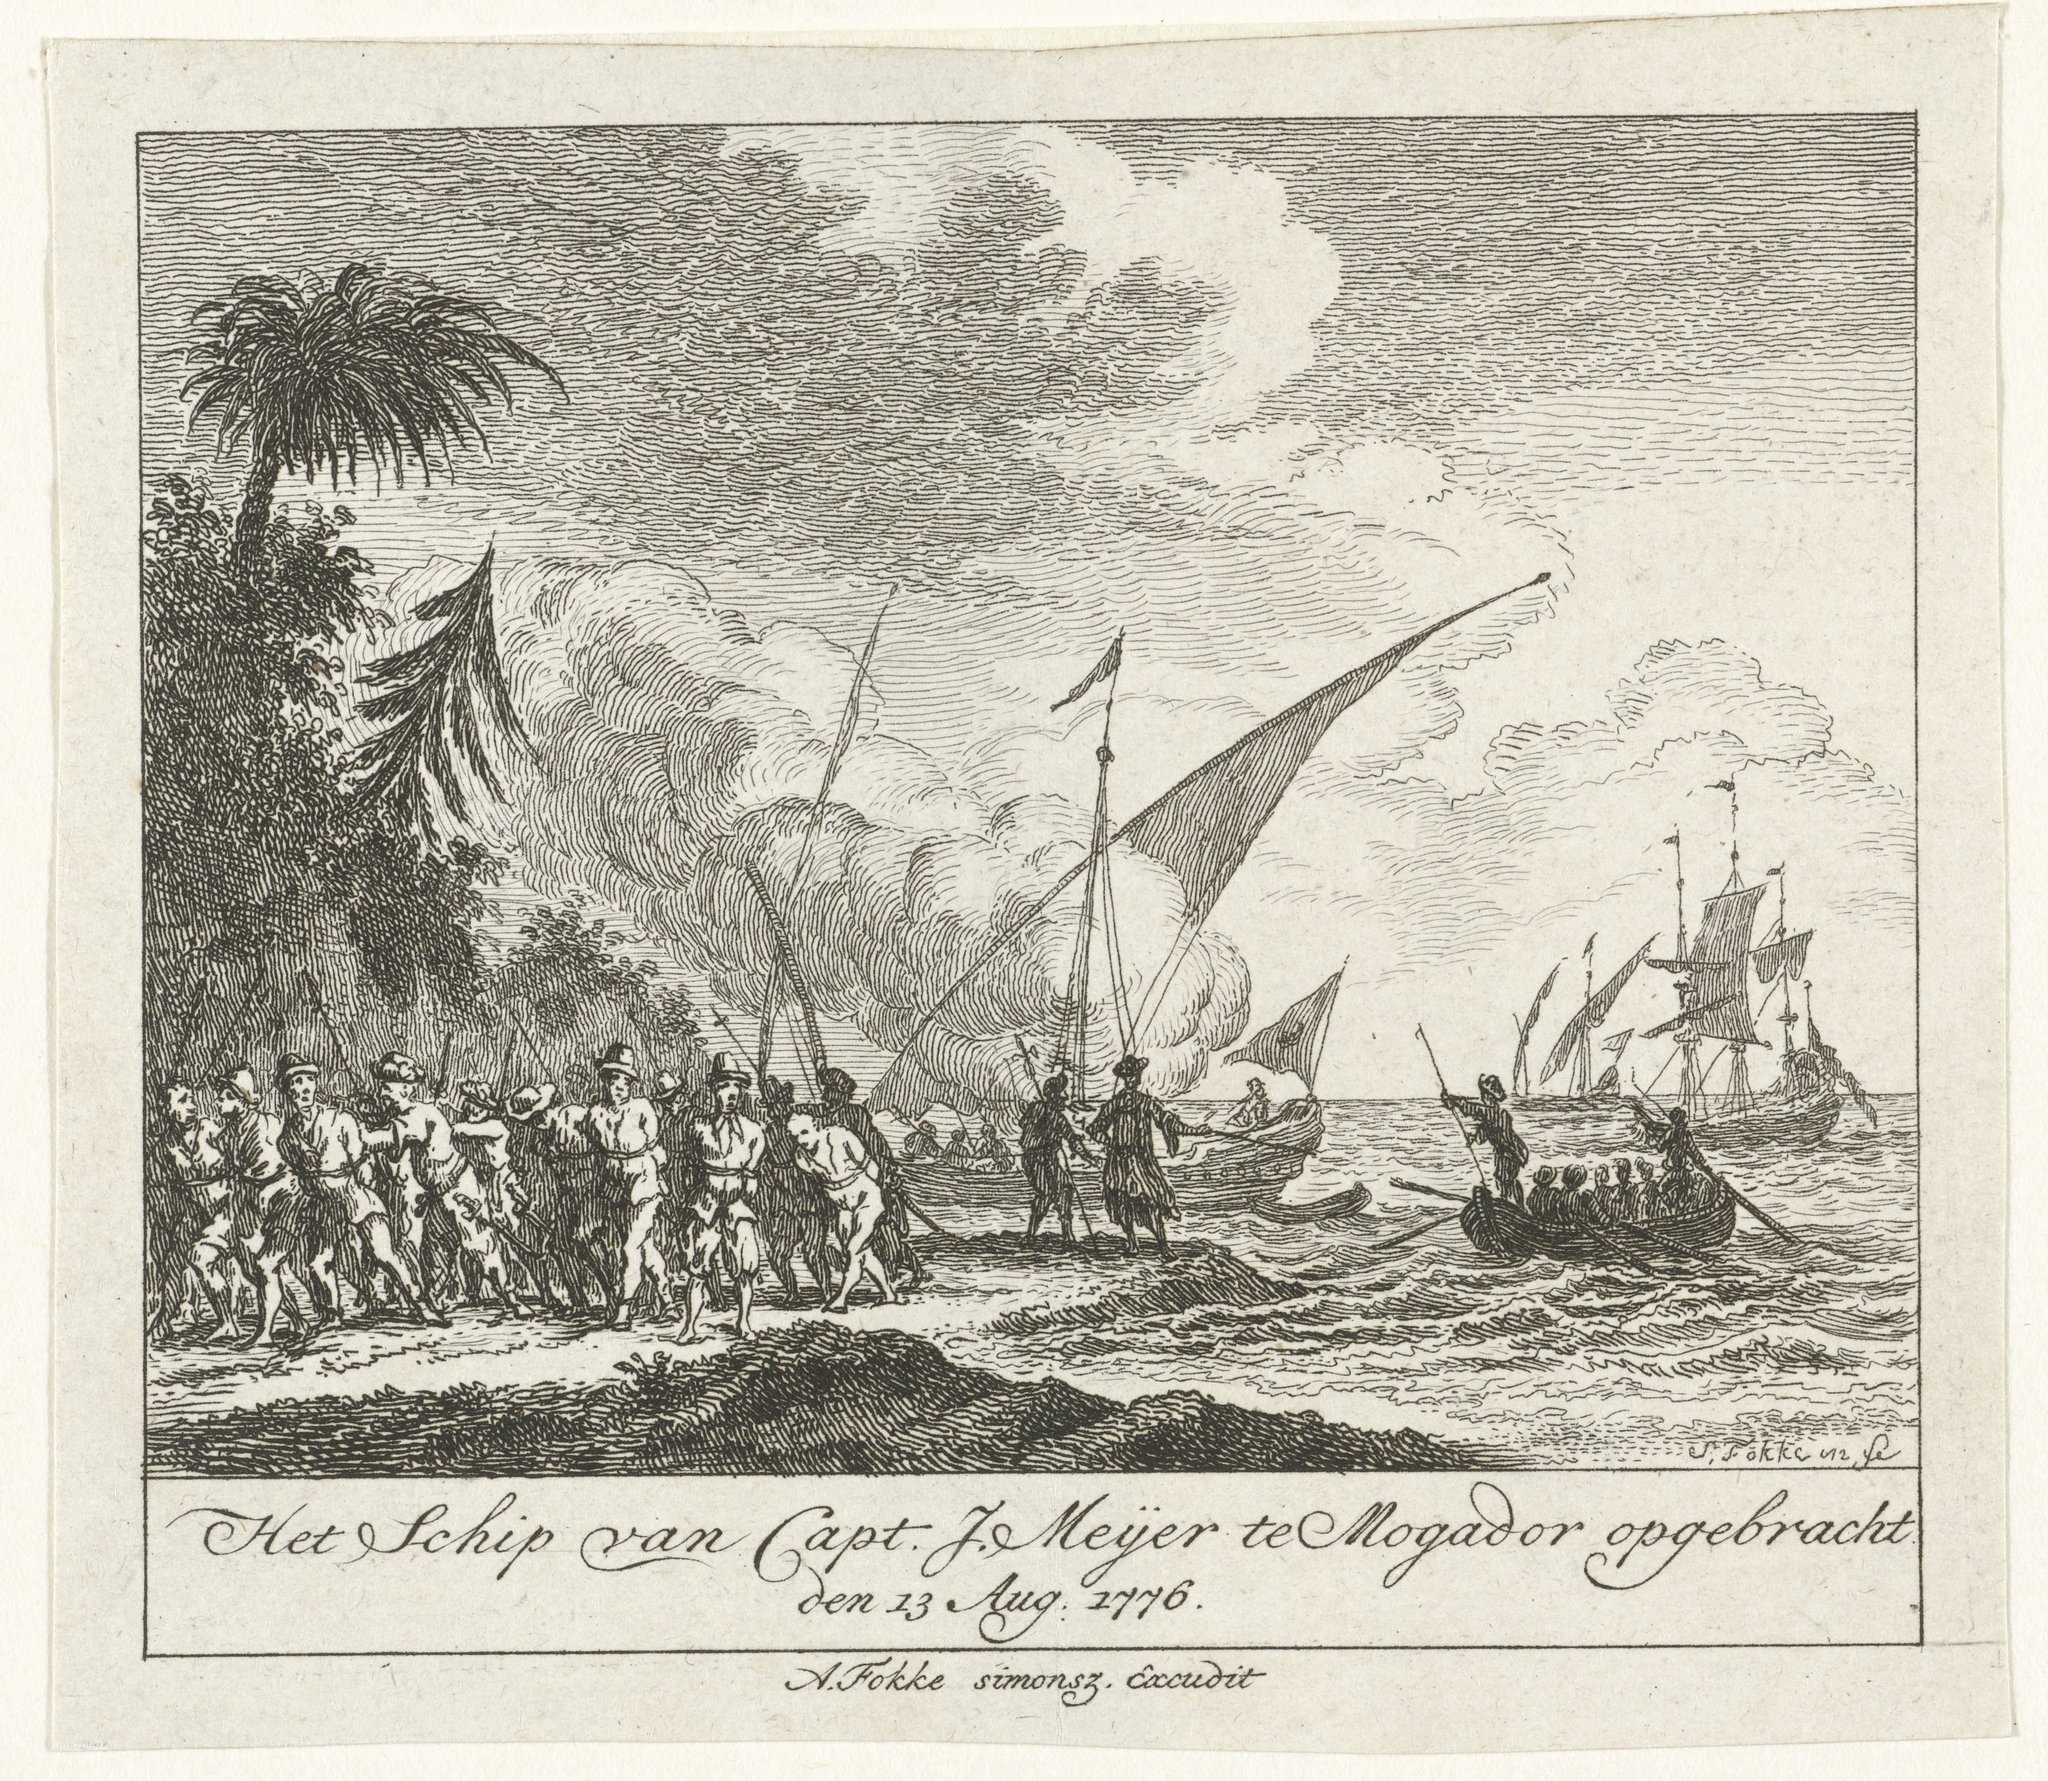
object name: print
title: Het Schip van Capt. J. Meijer te Mogador opgebracht den 13. Aug. 1776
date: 1776-1784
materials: paper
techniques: etching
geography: northern netherlands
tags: hostage (after the battle) (+ naval force)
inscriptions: collector's mark: Lugt 2228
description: Opvarenden van het schip van kapitein J. Meijer zijn voor de kust van Marokko gevangengenomen en worden vastgebonden het land opgedreven. In de verte ligt het in beslag genomen schip.